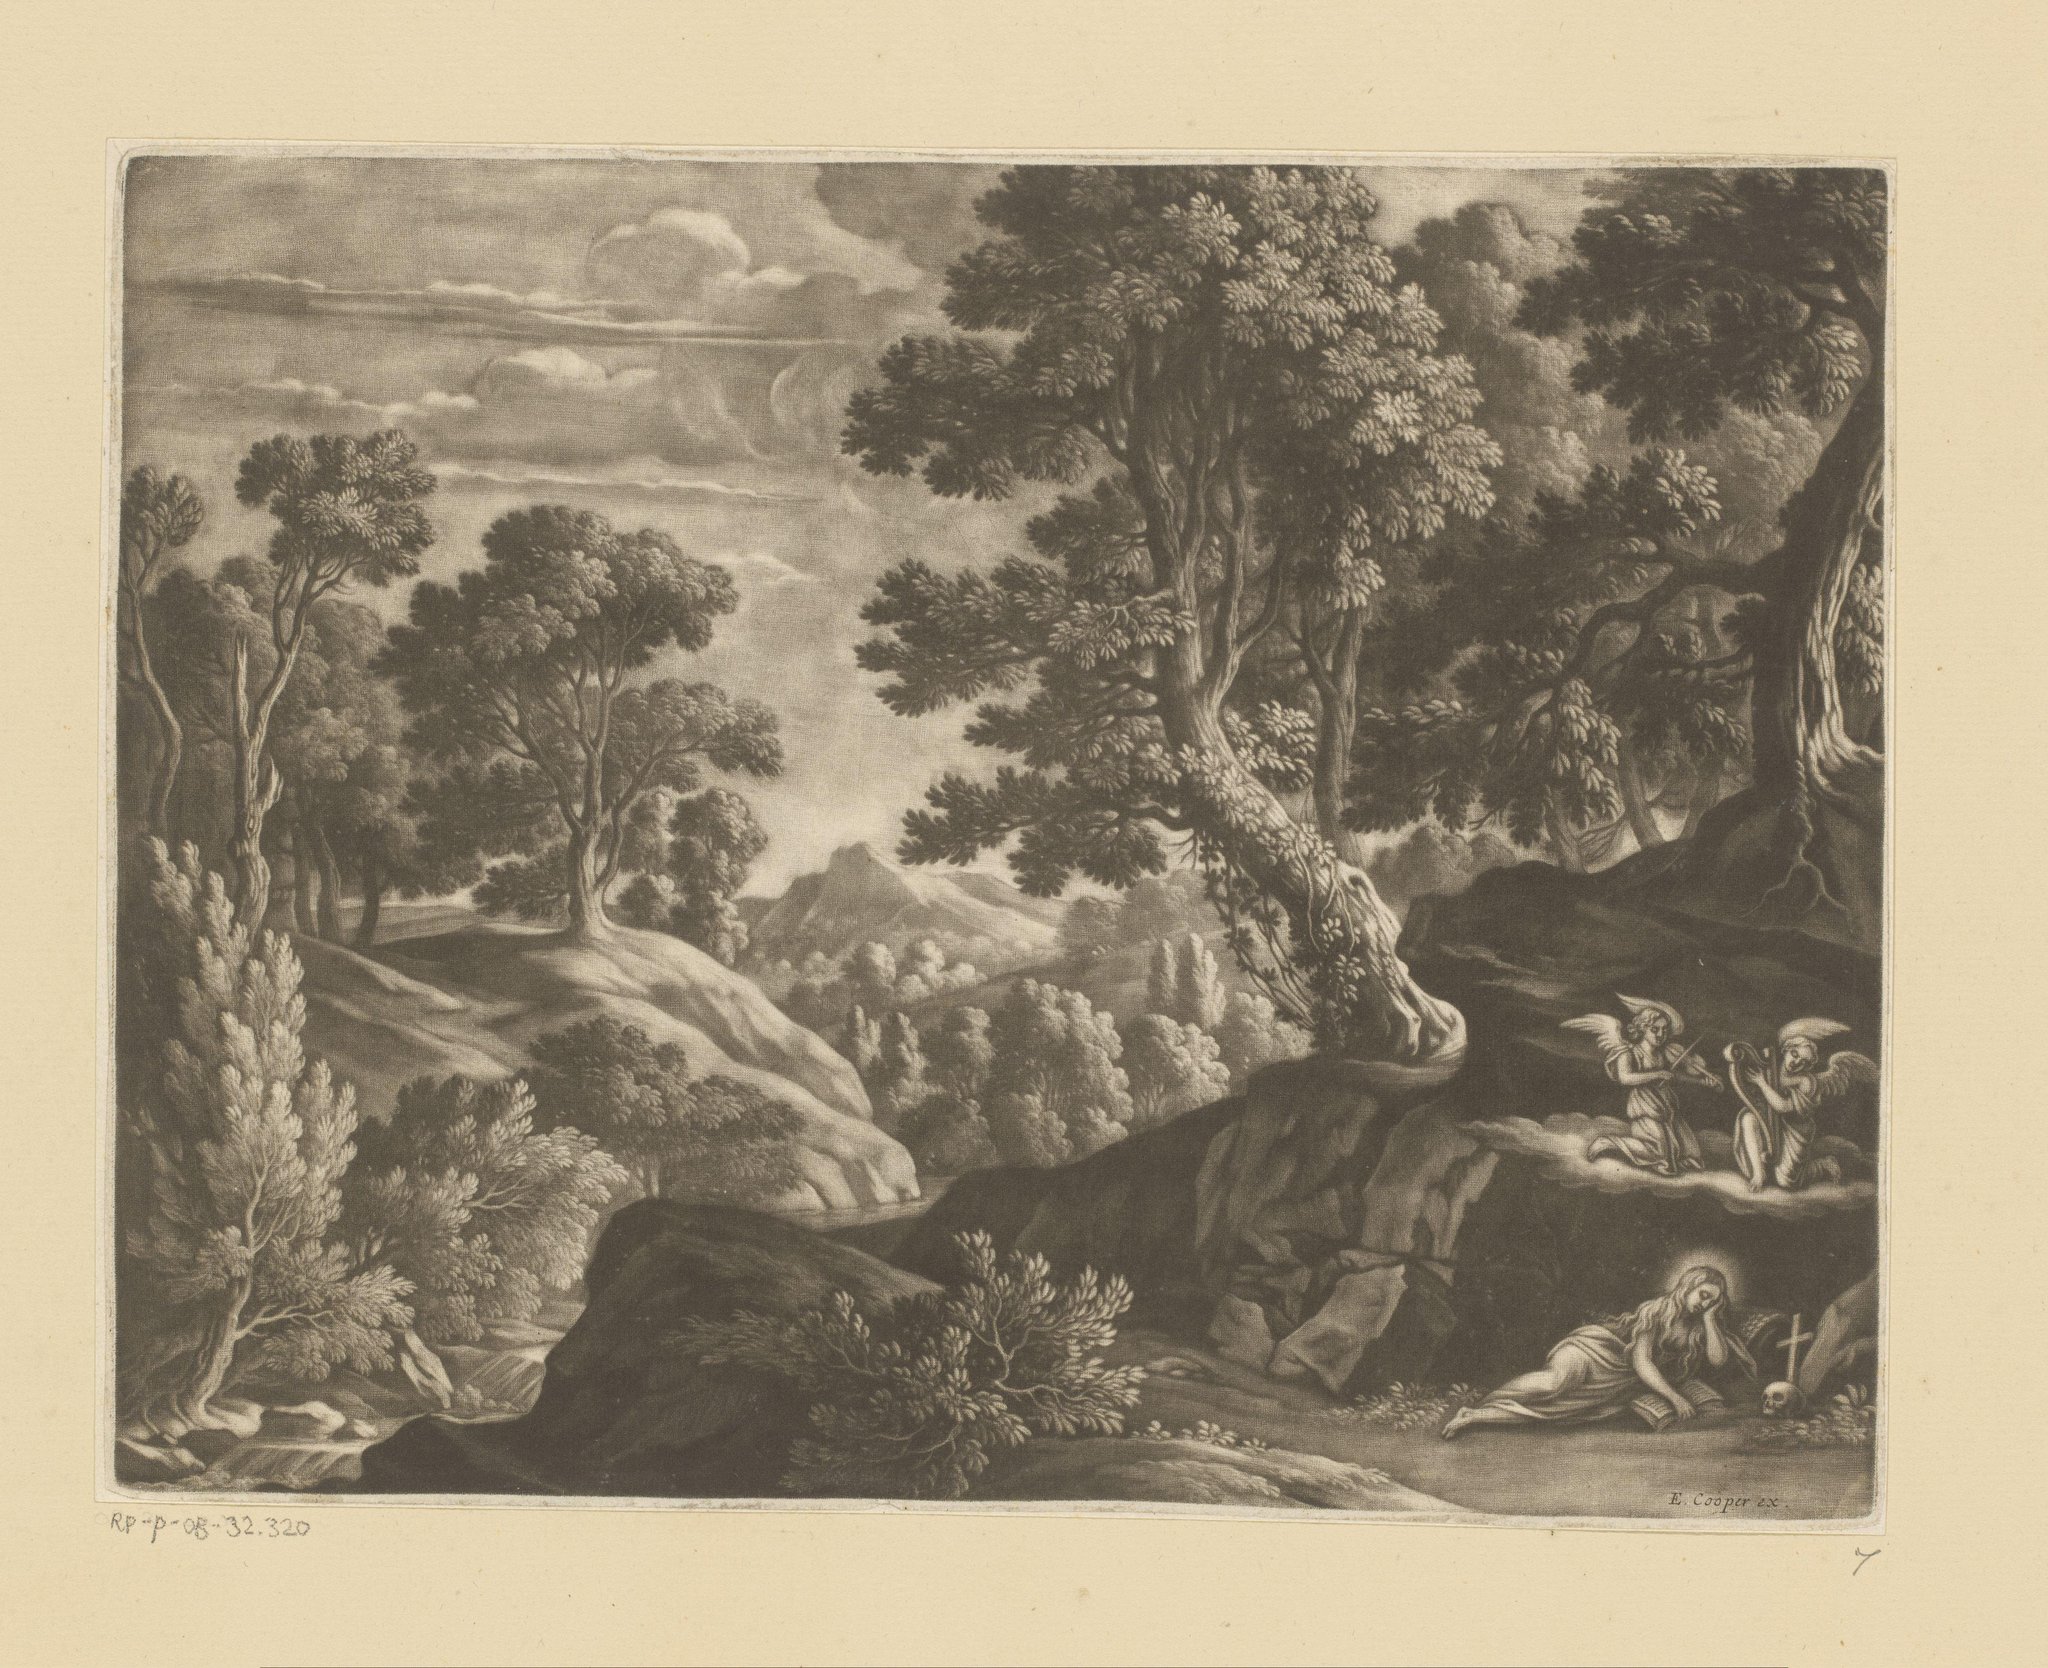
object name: print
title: H. Maria Magdalena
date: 1682-1725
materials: paper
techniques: mezzotint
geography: london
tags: low hill country (+ landscape with figures, staffage), the penitent harlot mary magdalene; possible attributes: book (or scroll), crown, crown of thorns, crucifix, jar of ointment, mirror, musical instrument, palm-branch, rosary, scourge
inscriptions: collector's mark: Lugt 240